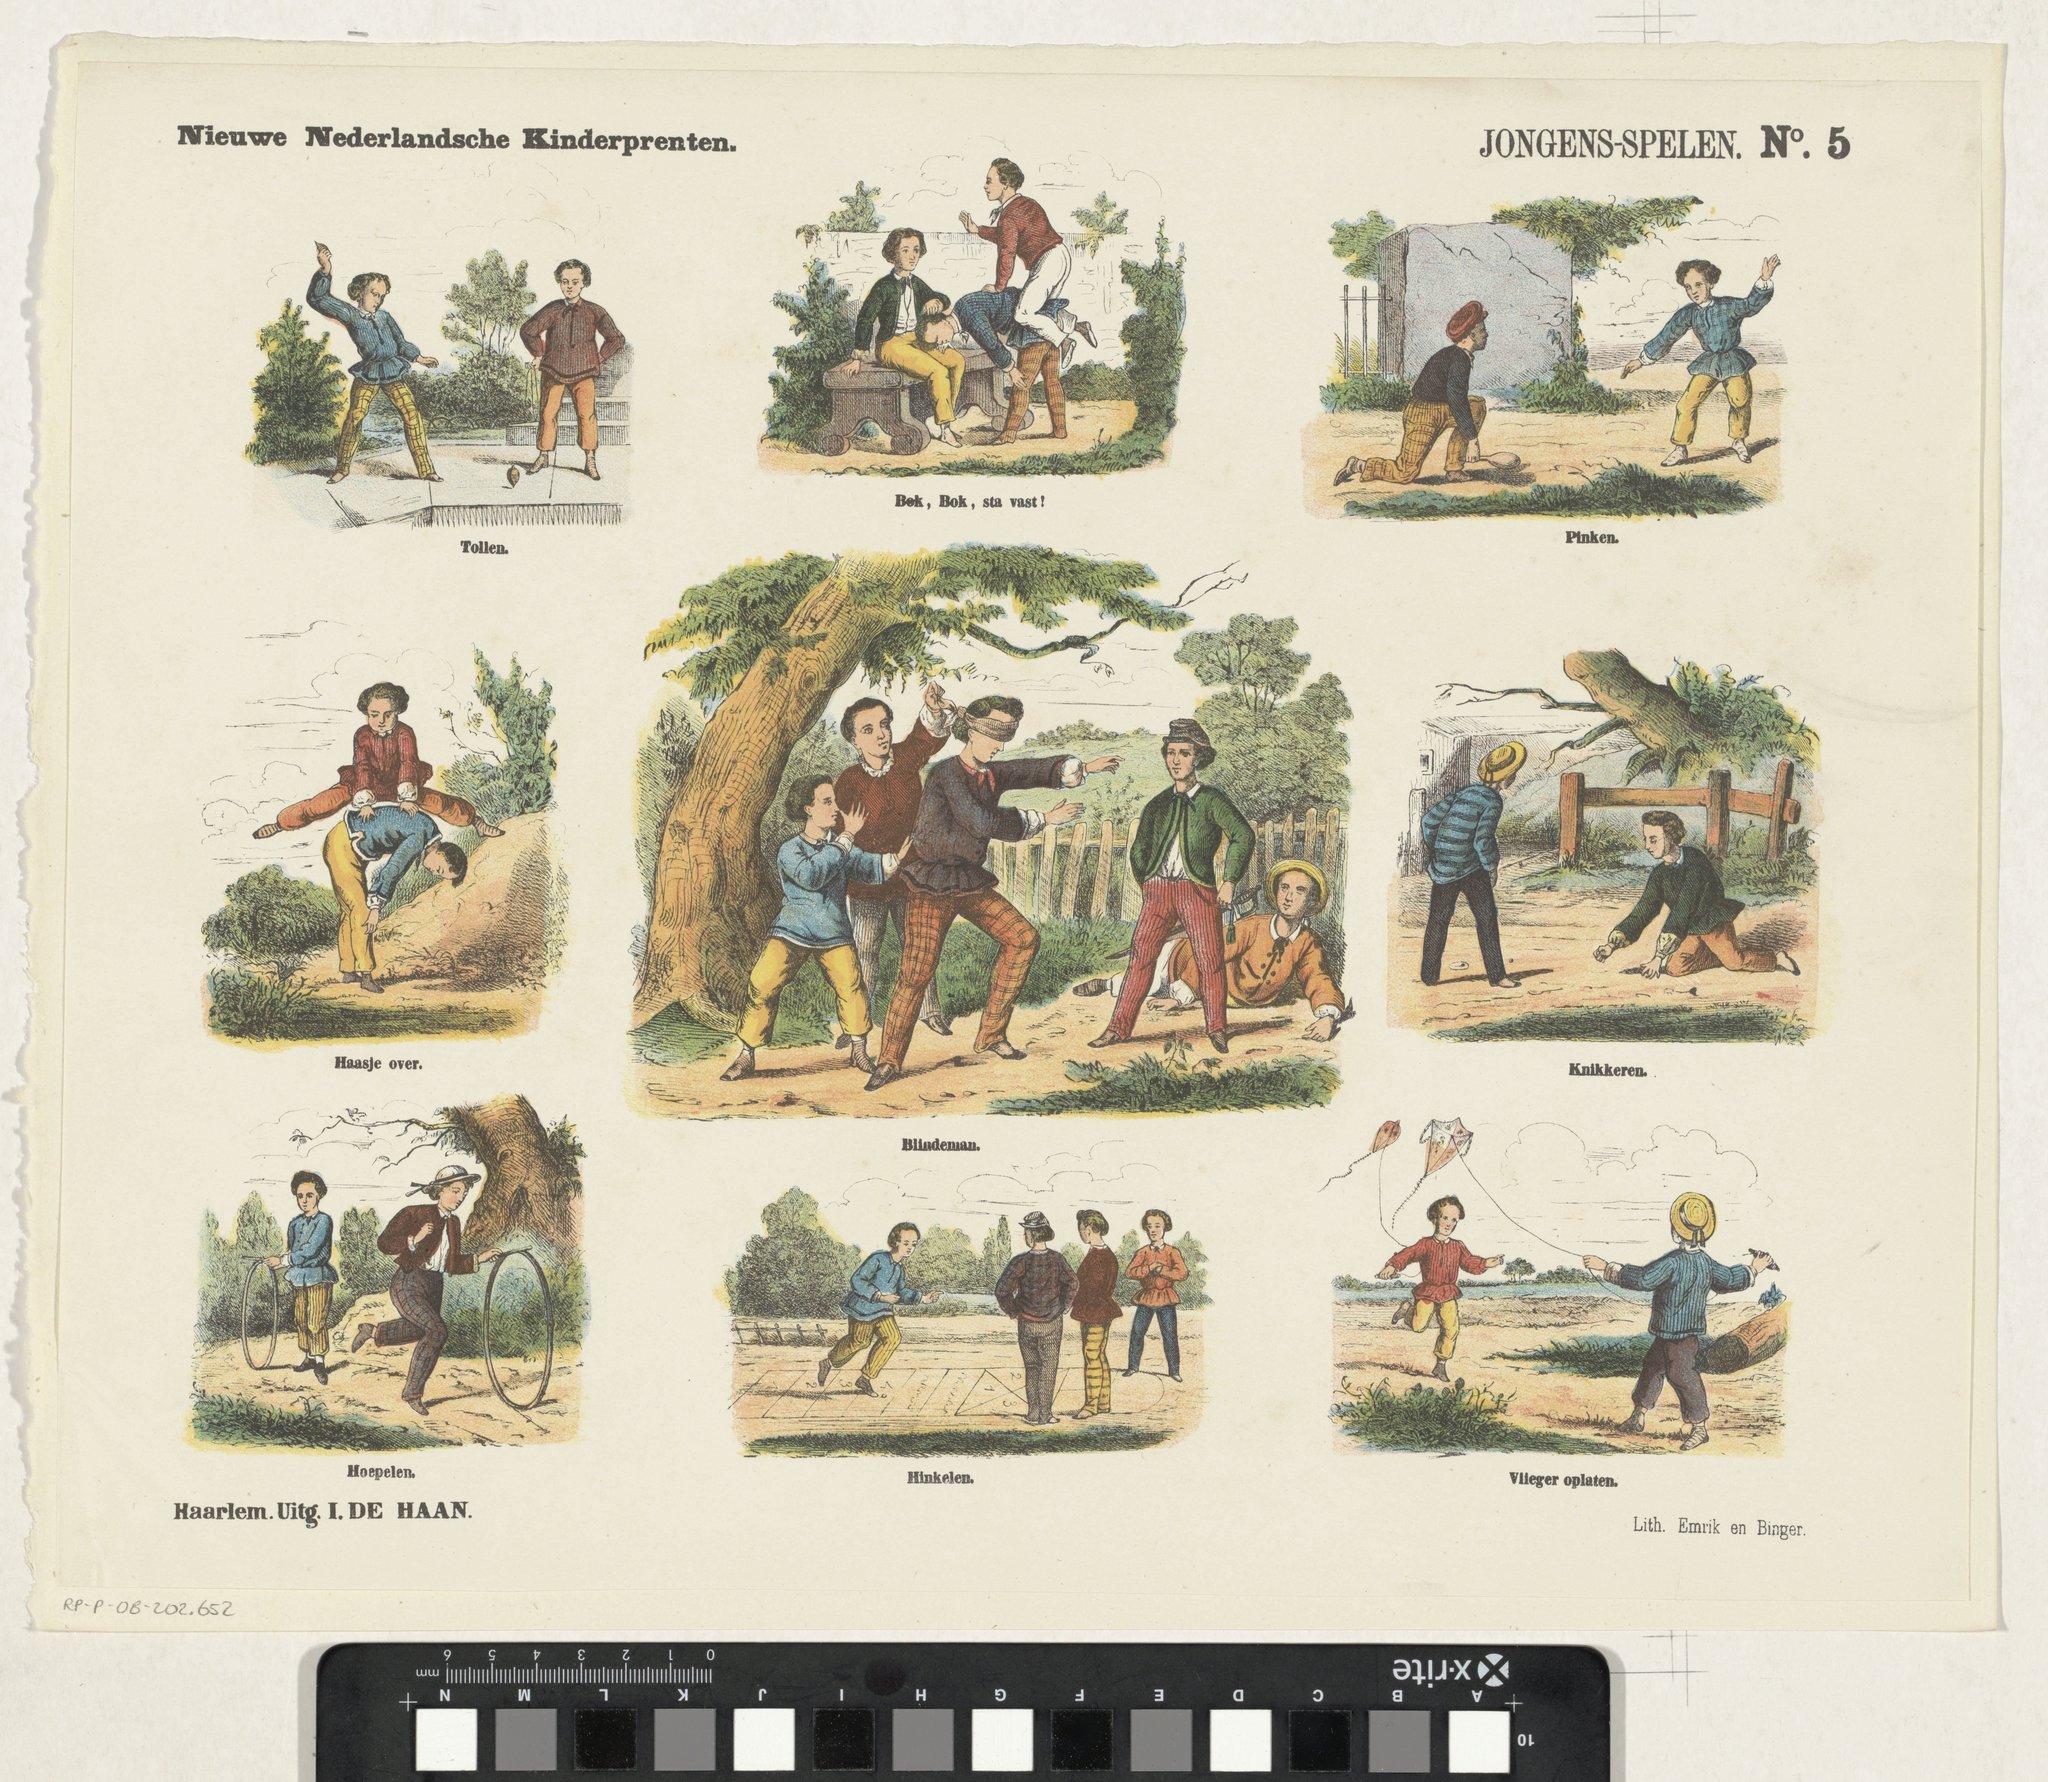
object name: print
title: Jongens-spelen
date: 1875-1903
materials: paper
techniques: lithograph, letterpress printing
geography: haarlem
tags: children's games and plays, blind-man's buff, games using special objects (marbles, top, hoop, etc.)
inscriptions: collector's mark: Lugt 2760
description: Blad met 9 voorstellingen van kinderspelen voor jongens, zoals blindemannetje, hinkelen en knikkeren. Onder elke afbeelding een onderschrift. Genummerd rechtsboven: No. 5.